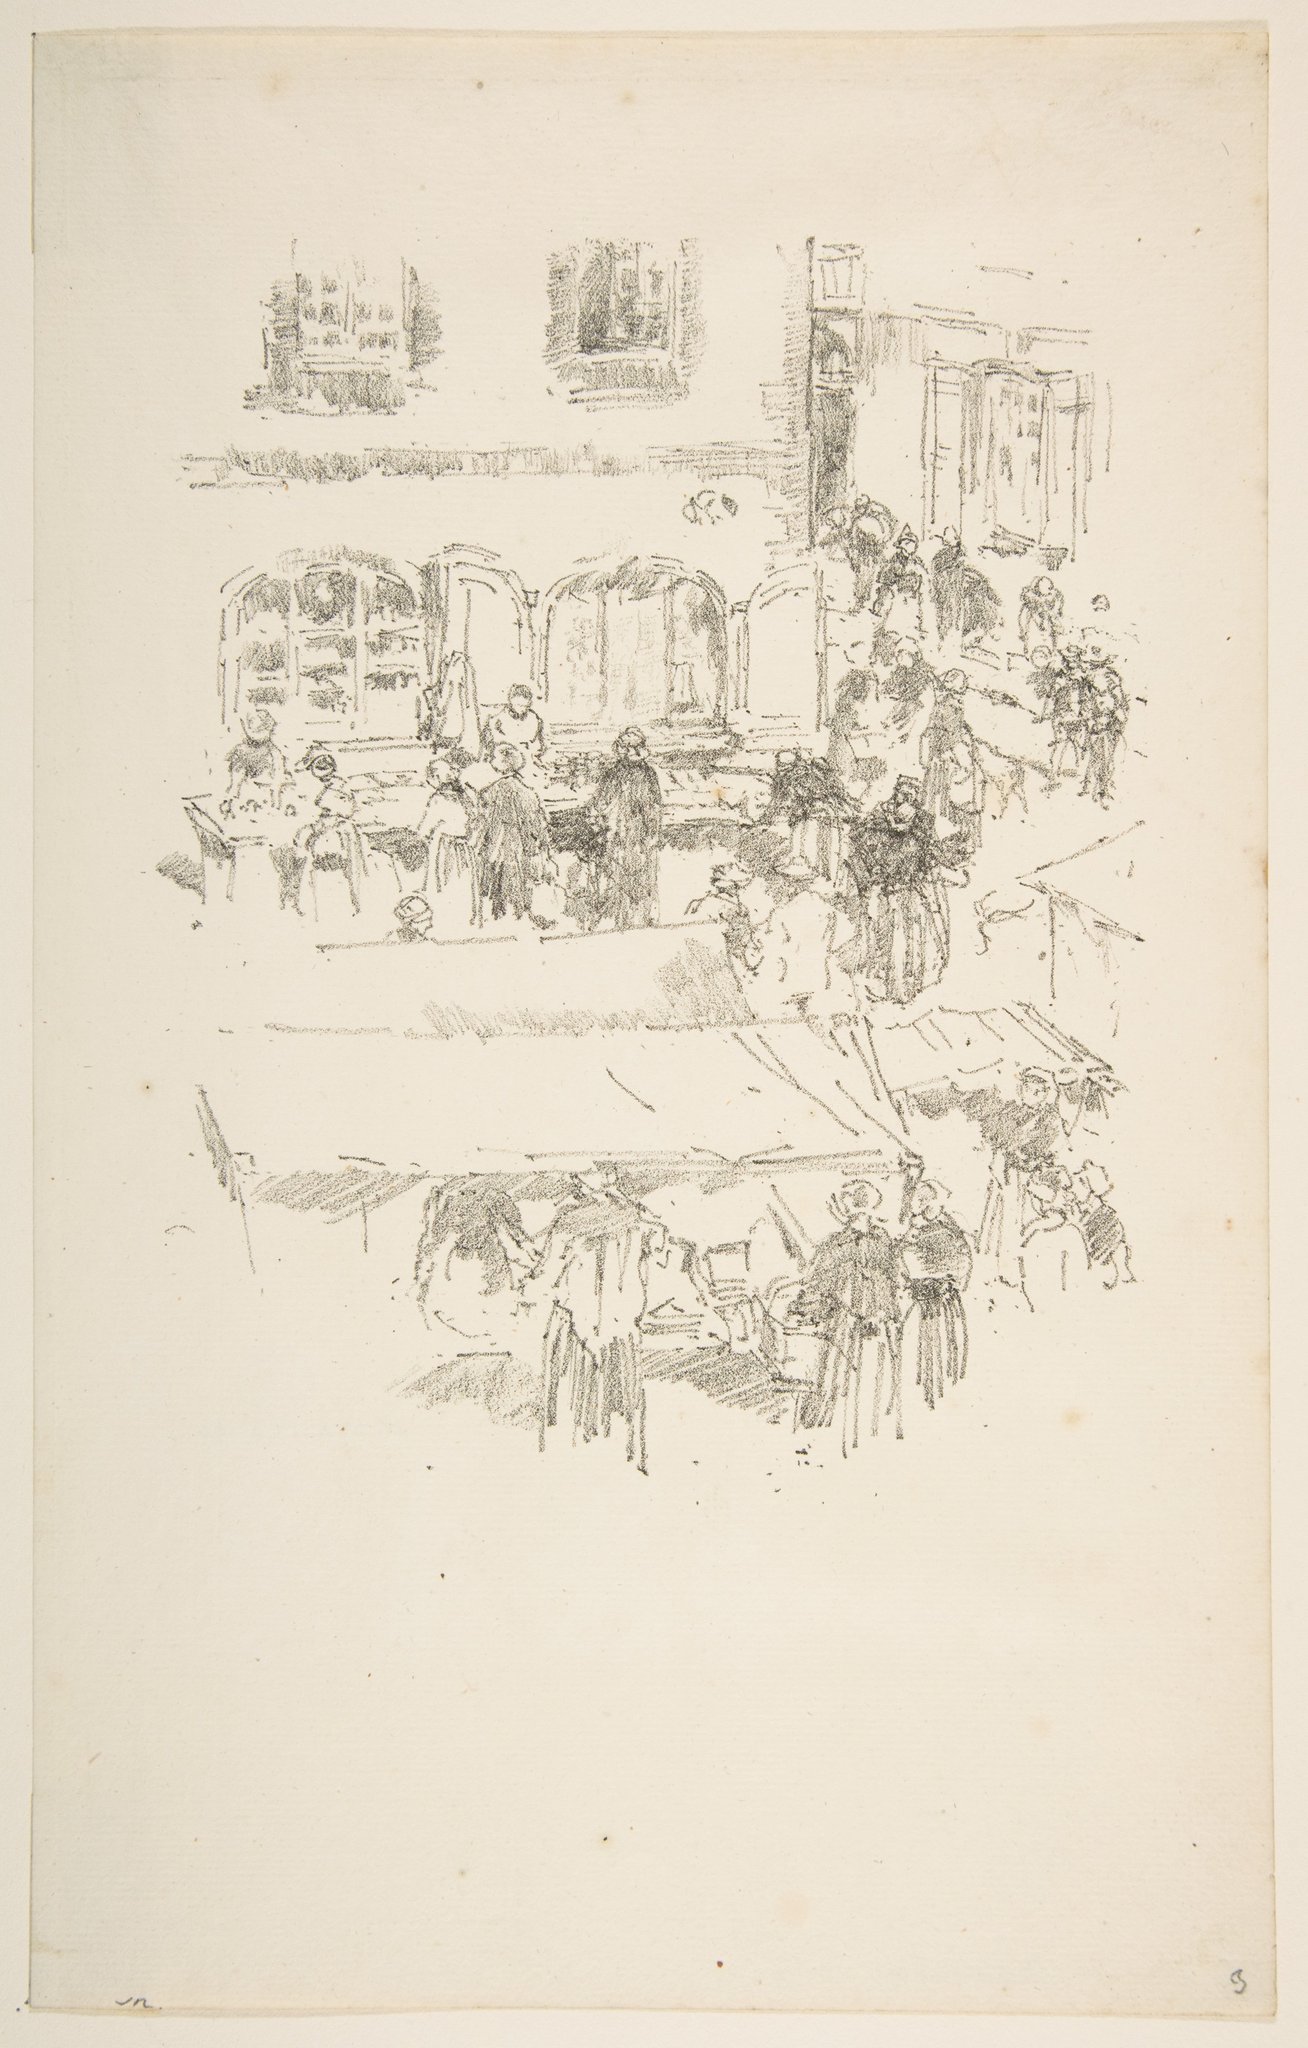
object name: print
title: The Market Place, Vitré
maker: james mcneill whistler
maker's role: artist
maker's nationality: american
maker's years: 1834-1903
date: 1893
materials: ink, paper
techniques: printing, stumping, lithography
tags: human figures,markets